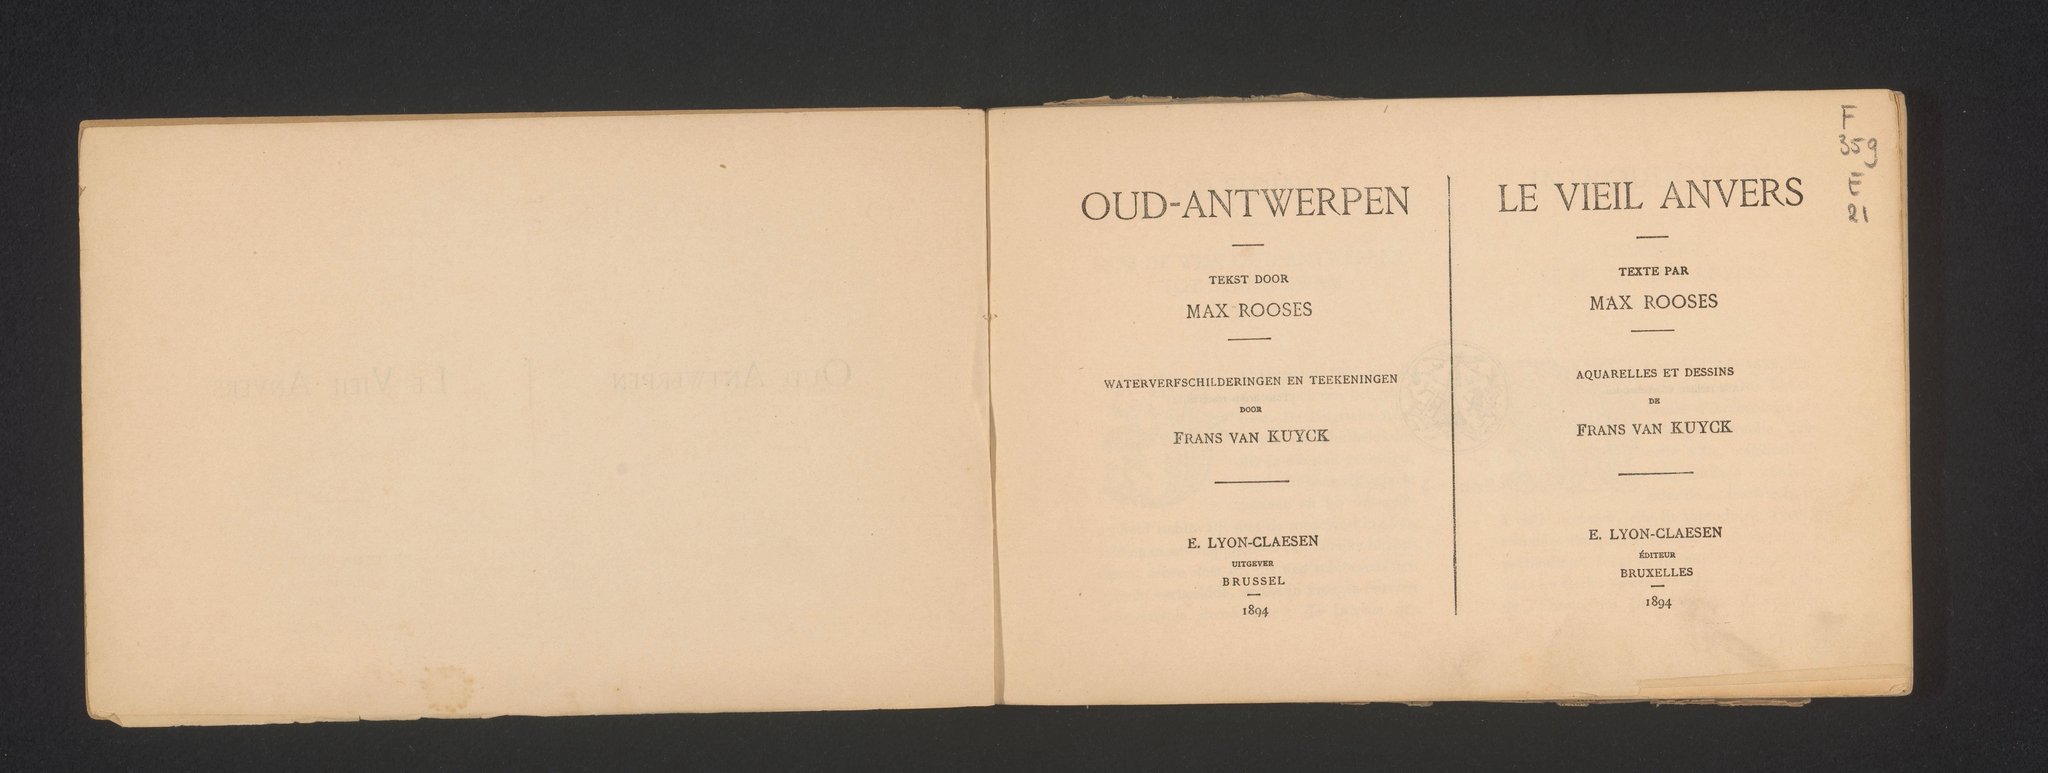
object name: book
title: Oud-Antwerpen Le vieil Anvers / tekst door Max Rooses; waterverfschilderingen en teekeningen van Frans Van Kuyck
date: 1894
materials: cardboard, paper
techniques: photograph, lithograph, printing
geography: brussels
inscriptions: annotation: ‘JULY/ 1988’, number: ‘300’